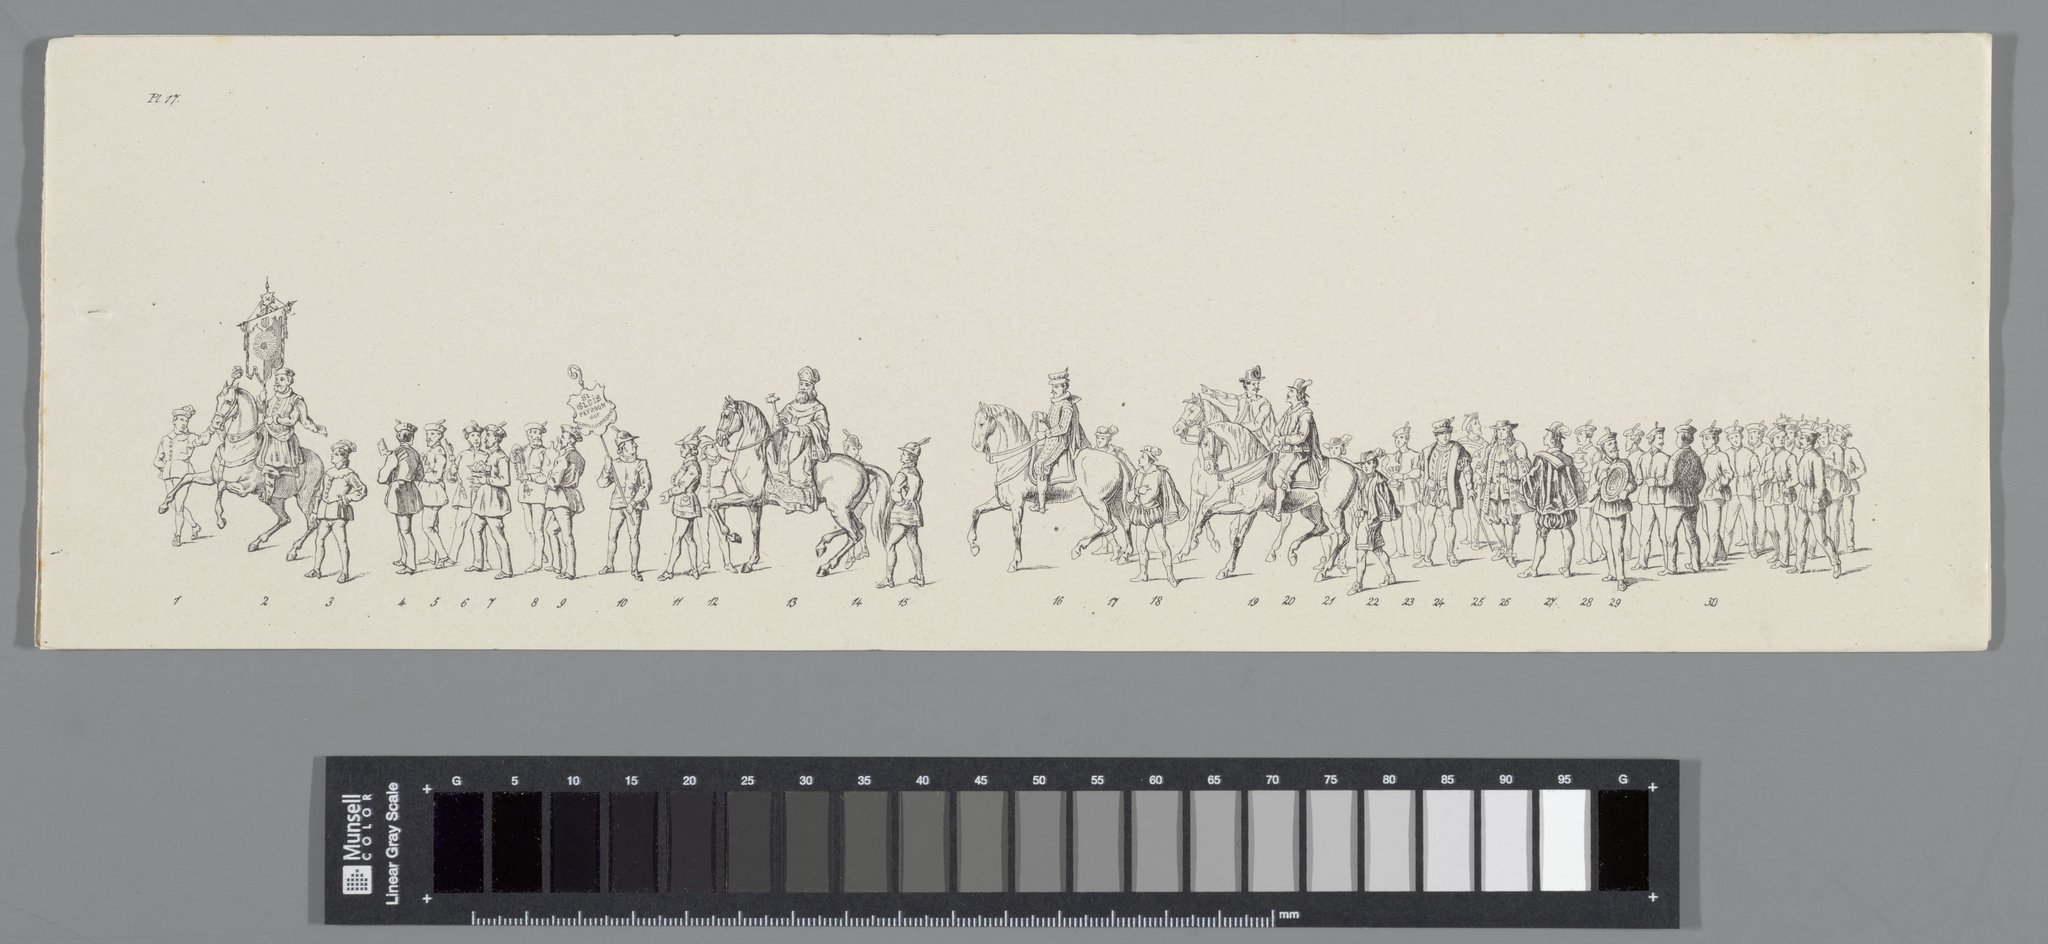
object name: print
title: Historische en Allegorische Optocht te Amsterdam. 12 mei 1874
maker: Anonymous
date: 1874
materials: paper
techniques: lithograph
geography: amsterdam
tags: brussels, willem iii (koning der nederlanden), public festivities at other royal events, not meant or mentioned above (+ parade, pageant, cavalcade ~ festive activities), modern professional organization, trade union, costumes used in pageants, amsterdam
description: Plaat nr. 17 met het deel van de optocht met leden van de Vereeniging van Winkeliers, Fabrikanten en Gezellen in het vak van Gouden, Zilveren en Diamanten werken, in historische kostuum. Onderdeel van een serie van 24 platen van de gekostumeerde historische en allegorische optocht gehouden te Amsterdam op 12 mei 1874, als onderdeel van de feestelijkheden tijdens de viering van het 25-jarige regeringsjubileum van koning Willem III.